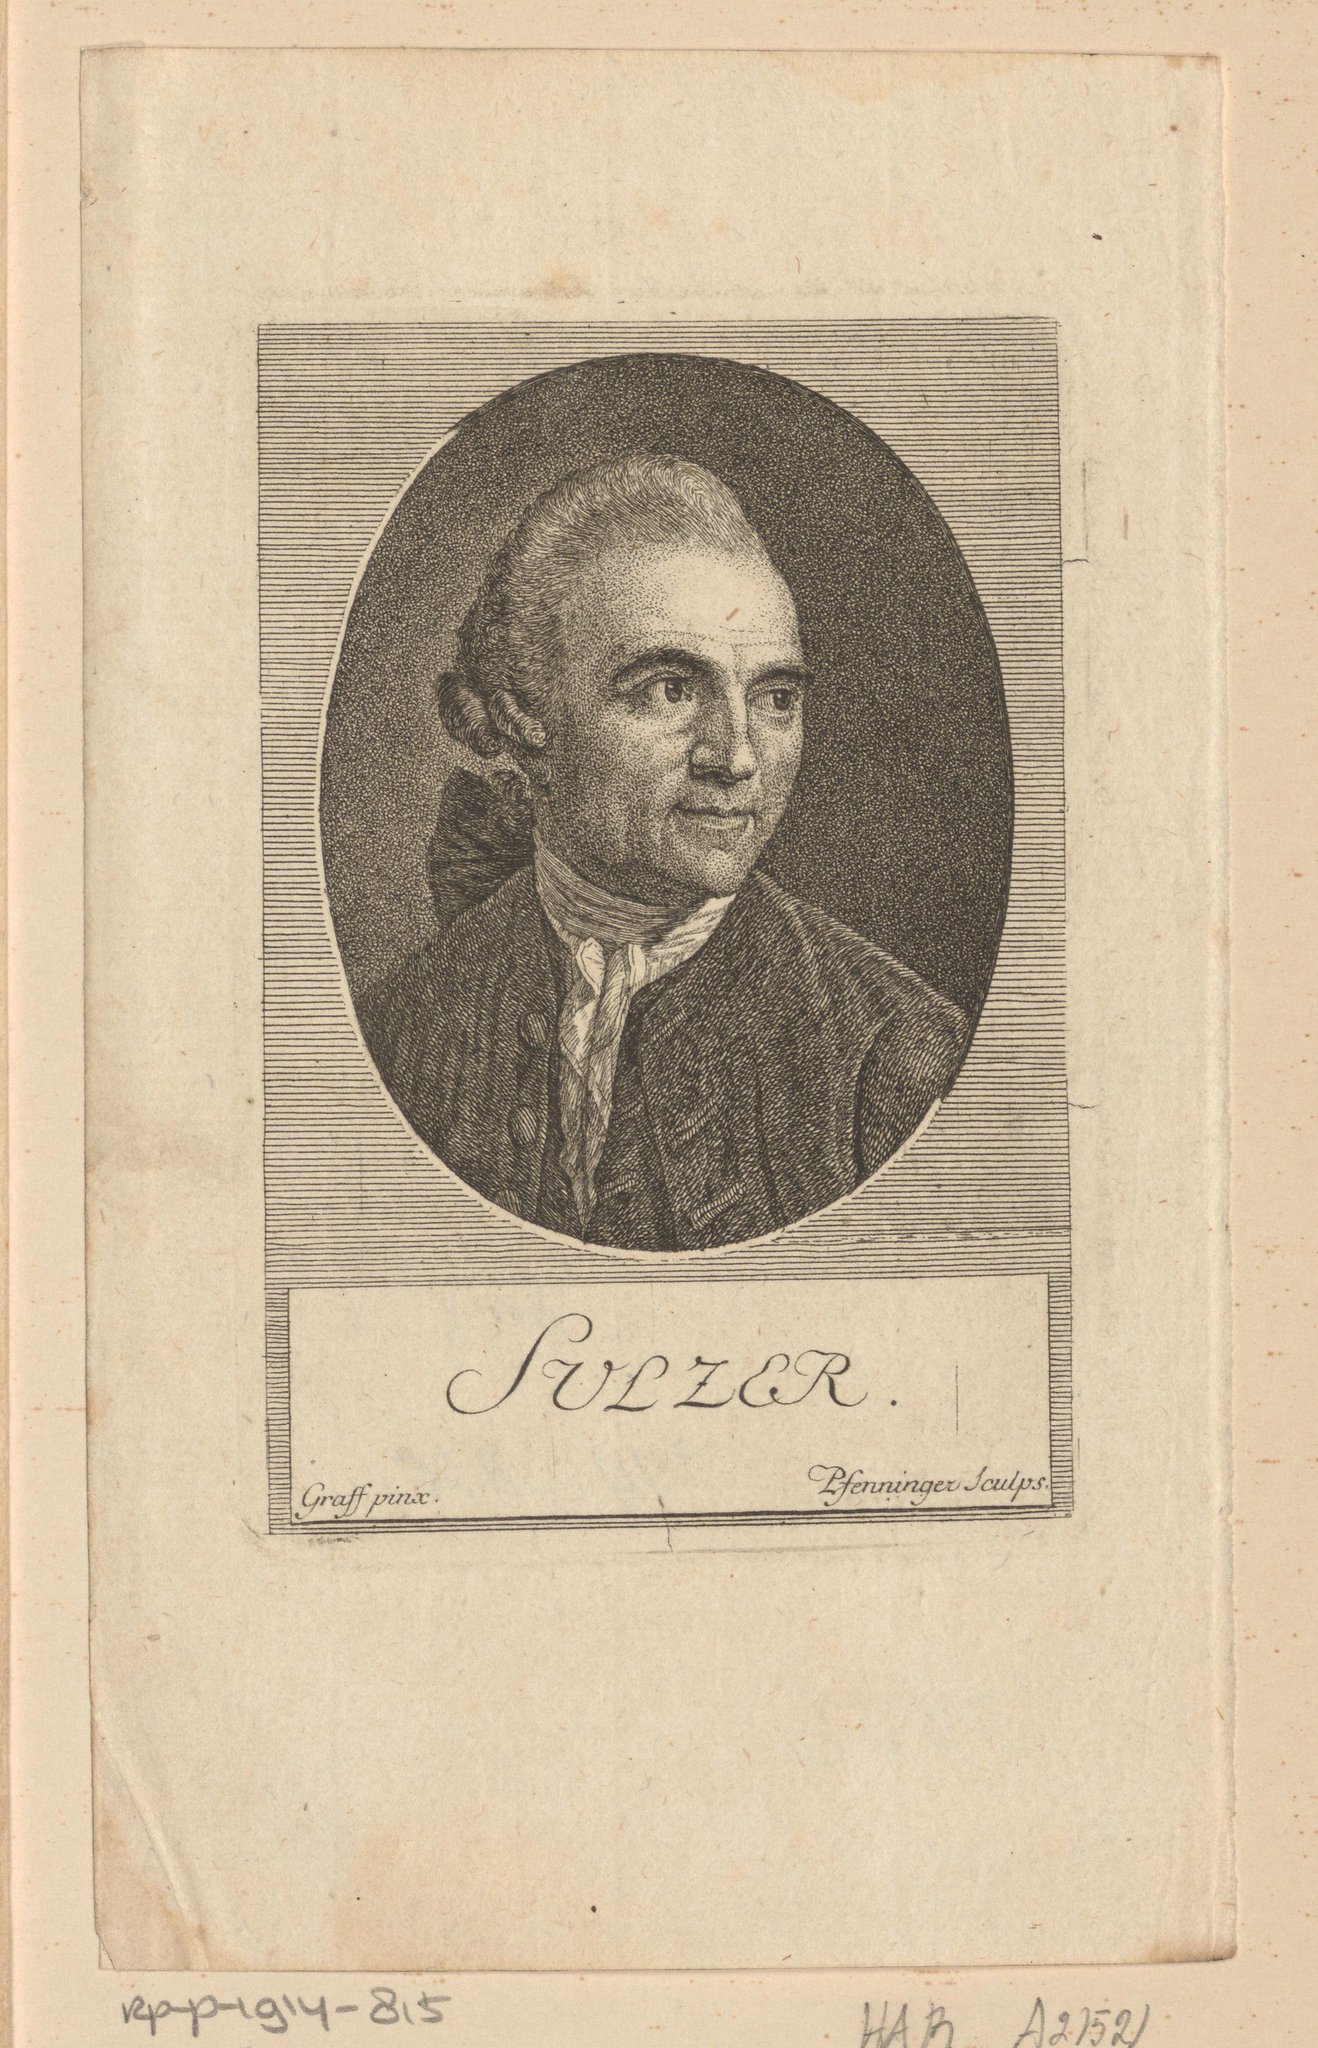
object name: print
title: Portret van Johann Georg Sulzer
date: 1759-1815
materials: paper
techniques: etching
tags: berlin, scholar, philosopher, historical persons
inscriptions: collector's mark: Lugt 2228